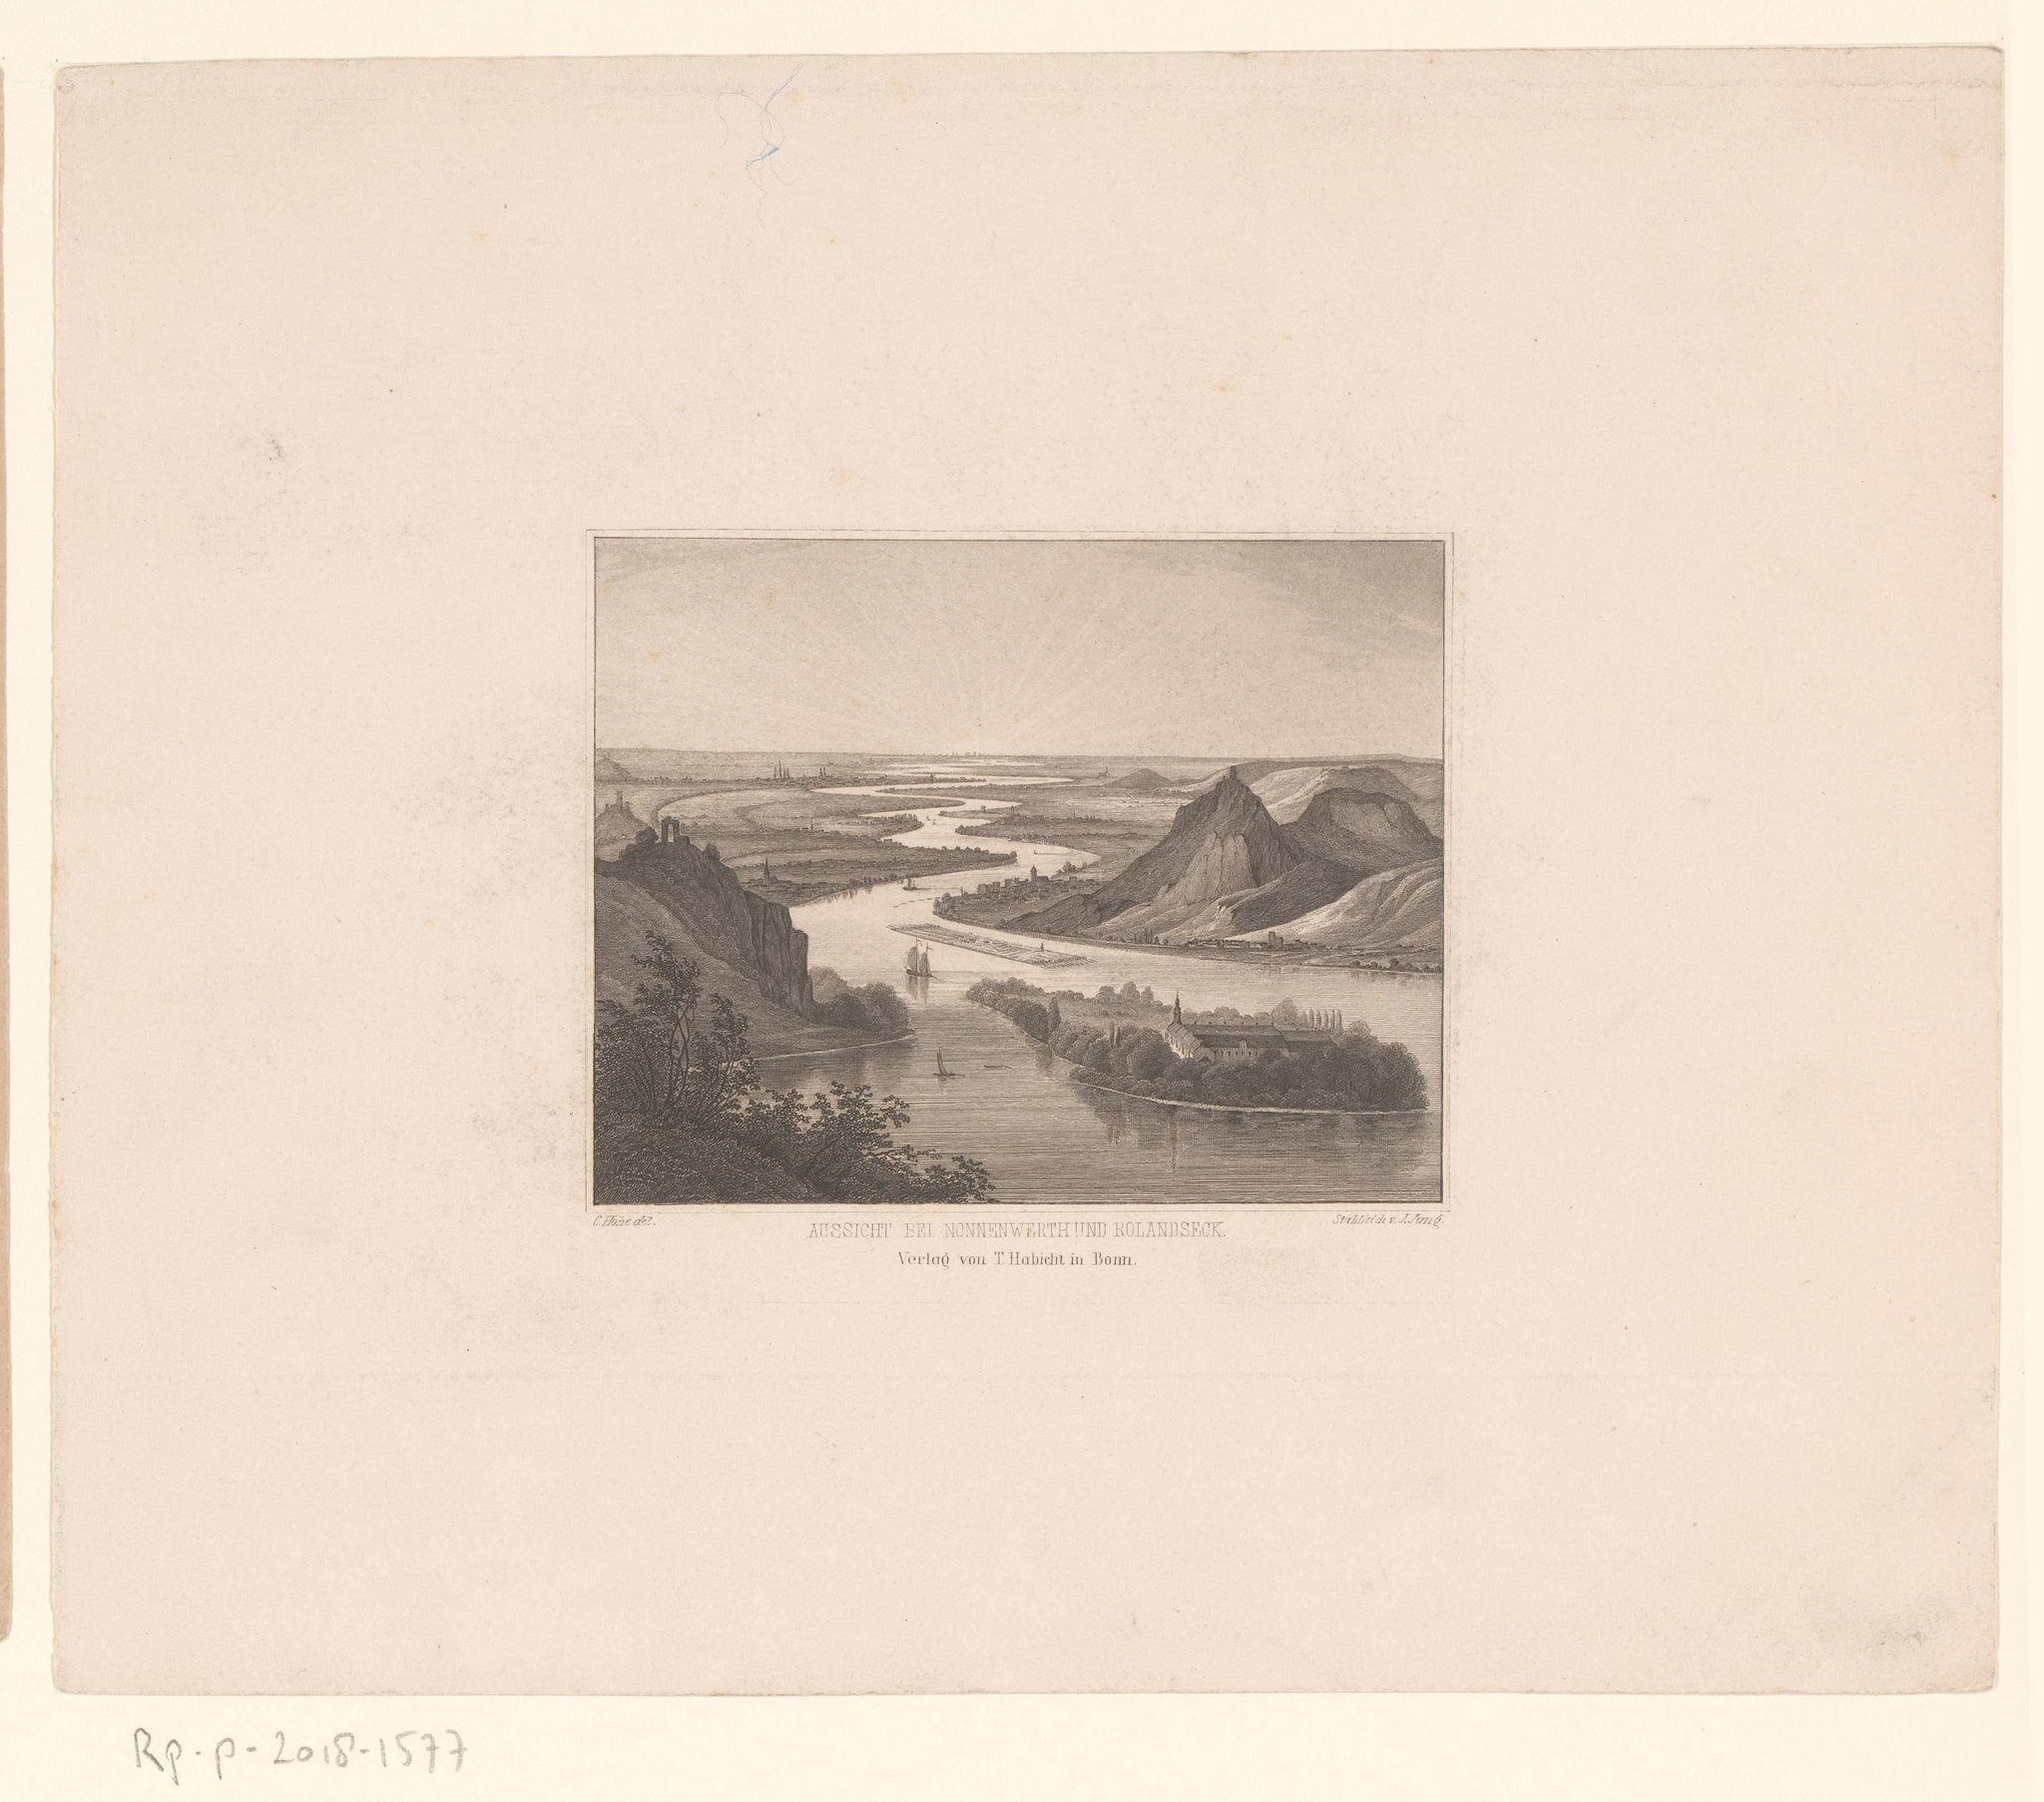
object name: print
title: Aussicht bei Nonnenwerth und Rolandseck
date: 1800-1899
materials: paper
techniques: engraving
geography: bonn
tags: prospect of village, silhouette of village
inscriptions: collector's mark: Lugt 2228